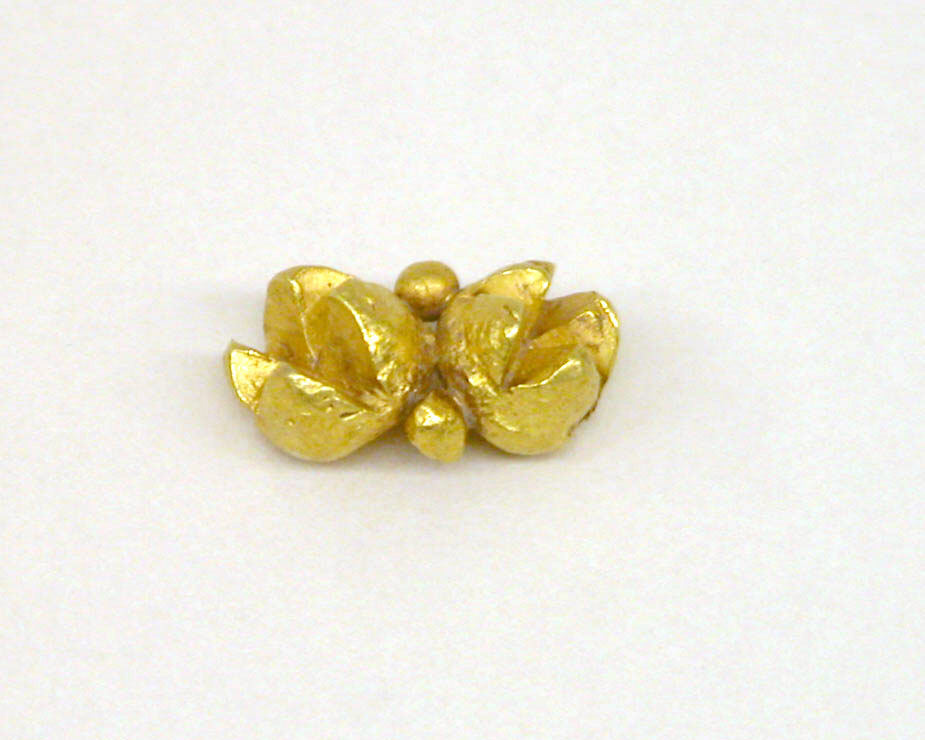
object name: ornament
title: Ornament with Double Lotus Motif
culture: indonesian, javanese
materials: gold